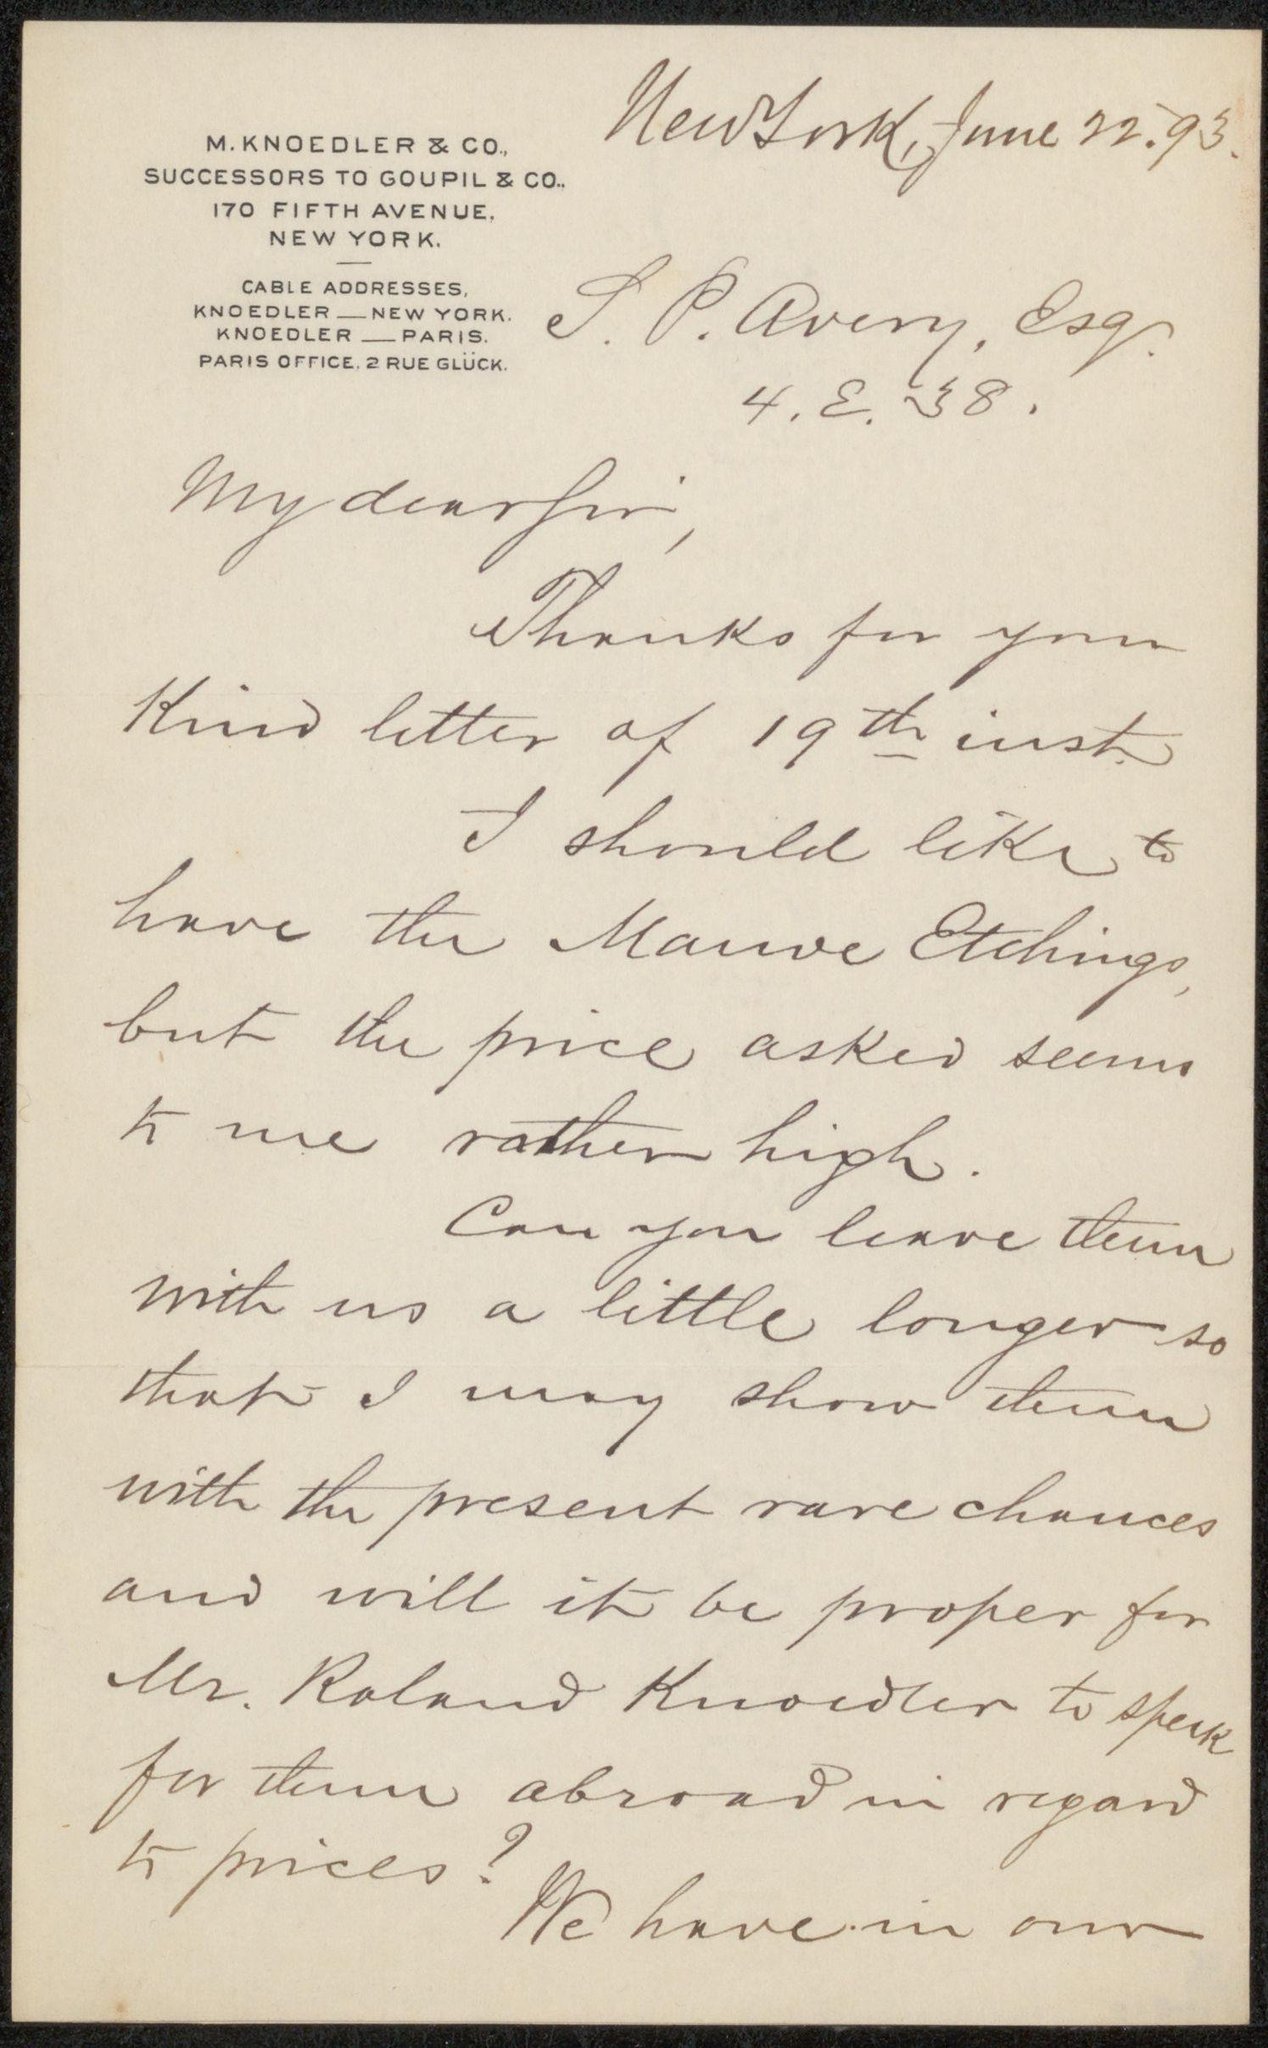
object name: letter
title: Brief aan Philip Zilcken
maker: l.f. roos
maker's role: manager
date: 1893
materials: ink, paper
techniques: pen, printing, writing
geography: new york city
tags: arnhem, painter, print maker, draughtsman, anton mauve, new york (city), samuel putnam avery, the hague, philip zilcken, art trade, art shop, the graphic arts, painting (including book-illumination, miniature-painting)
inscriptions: watermark, collector's mark: ‘RPK’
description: Deze brief is verstuurd als bijlage bij brief RP-D-1982-43-AVERY-30.